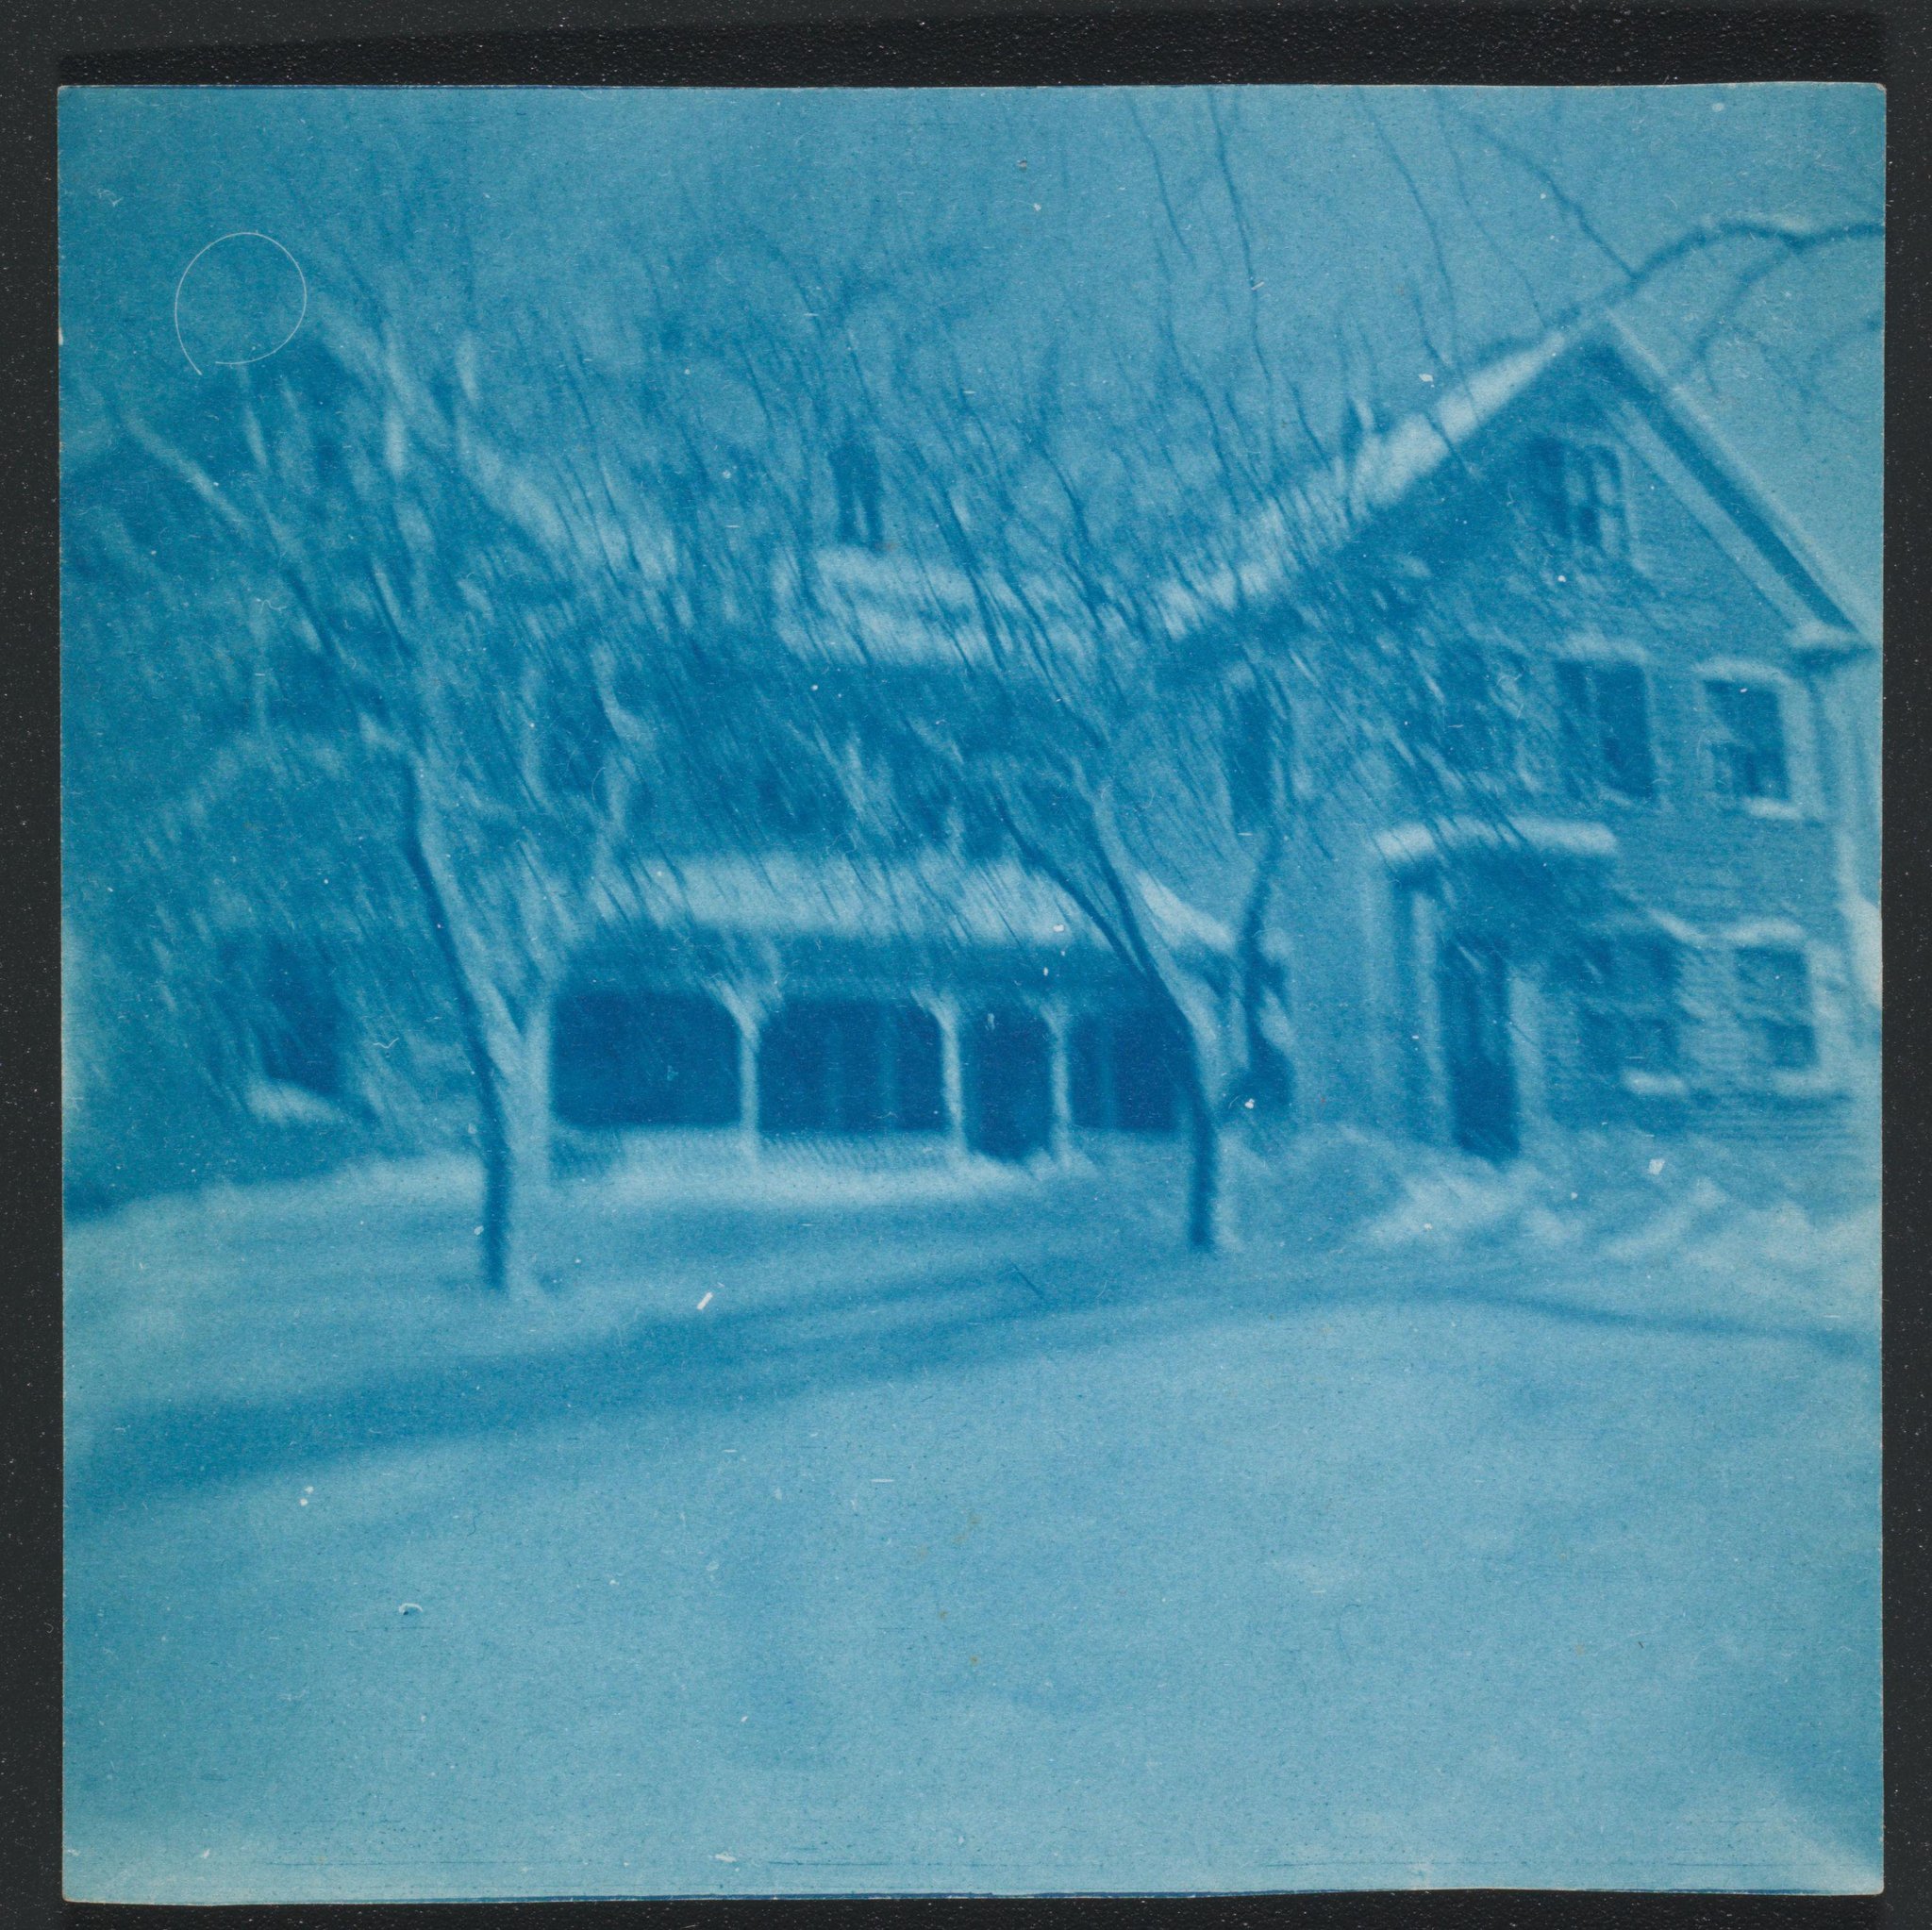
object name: photograph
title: Huis in de sneeuw, Verenigde Staten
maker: Anonymous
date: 1900-1920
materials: paper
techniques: cyanotype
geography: united states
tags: snow, country-house, united states of america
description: Onderdeel van Fotoalbum met 53 cyanotypieën van kinderen, paarden, huizen, boten en strandtaferelen in de Verenigde Staten.